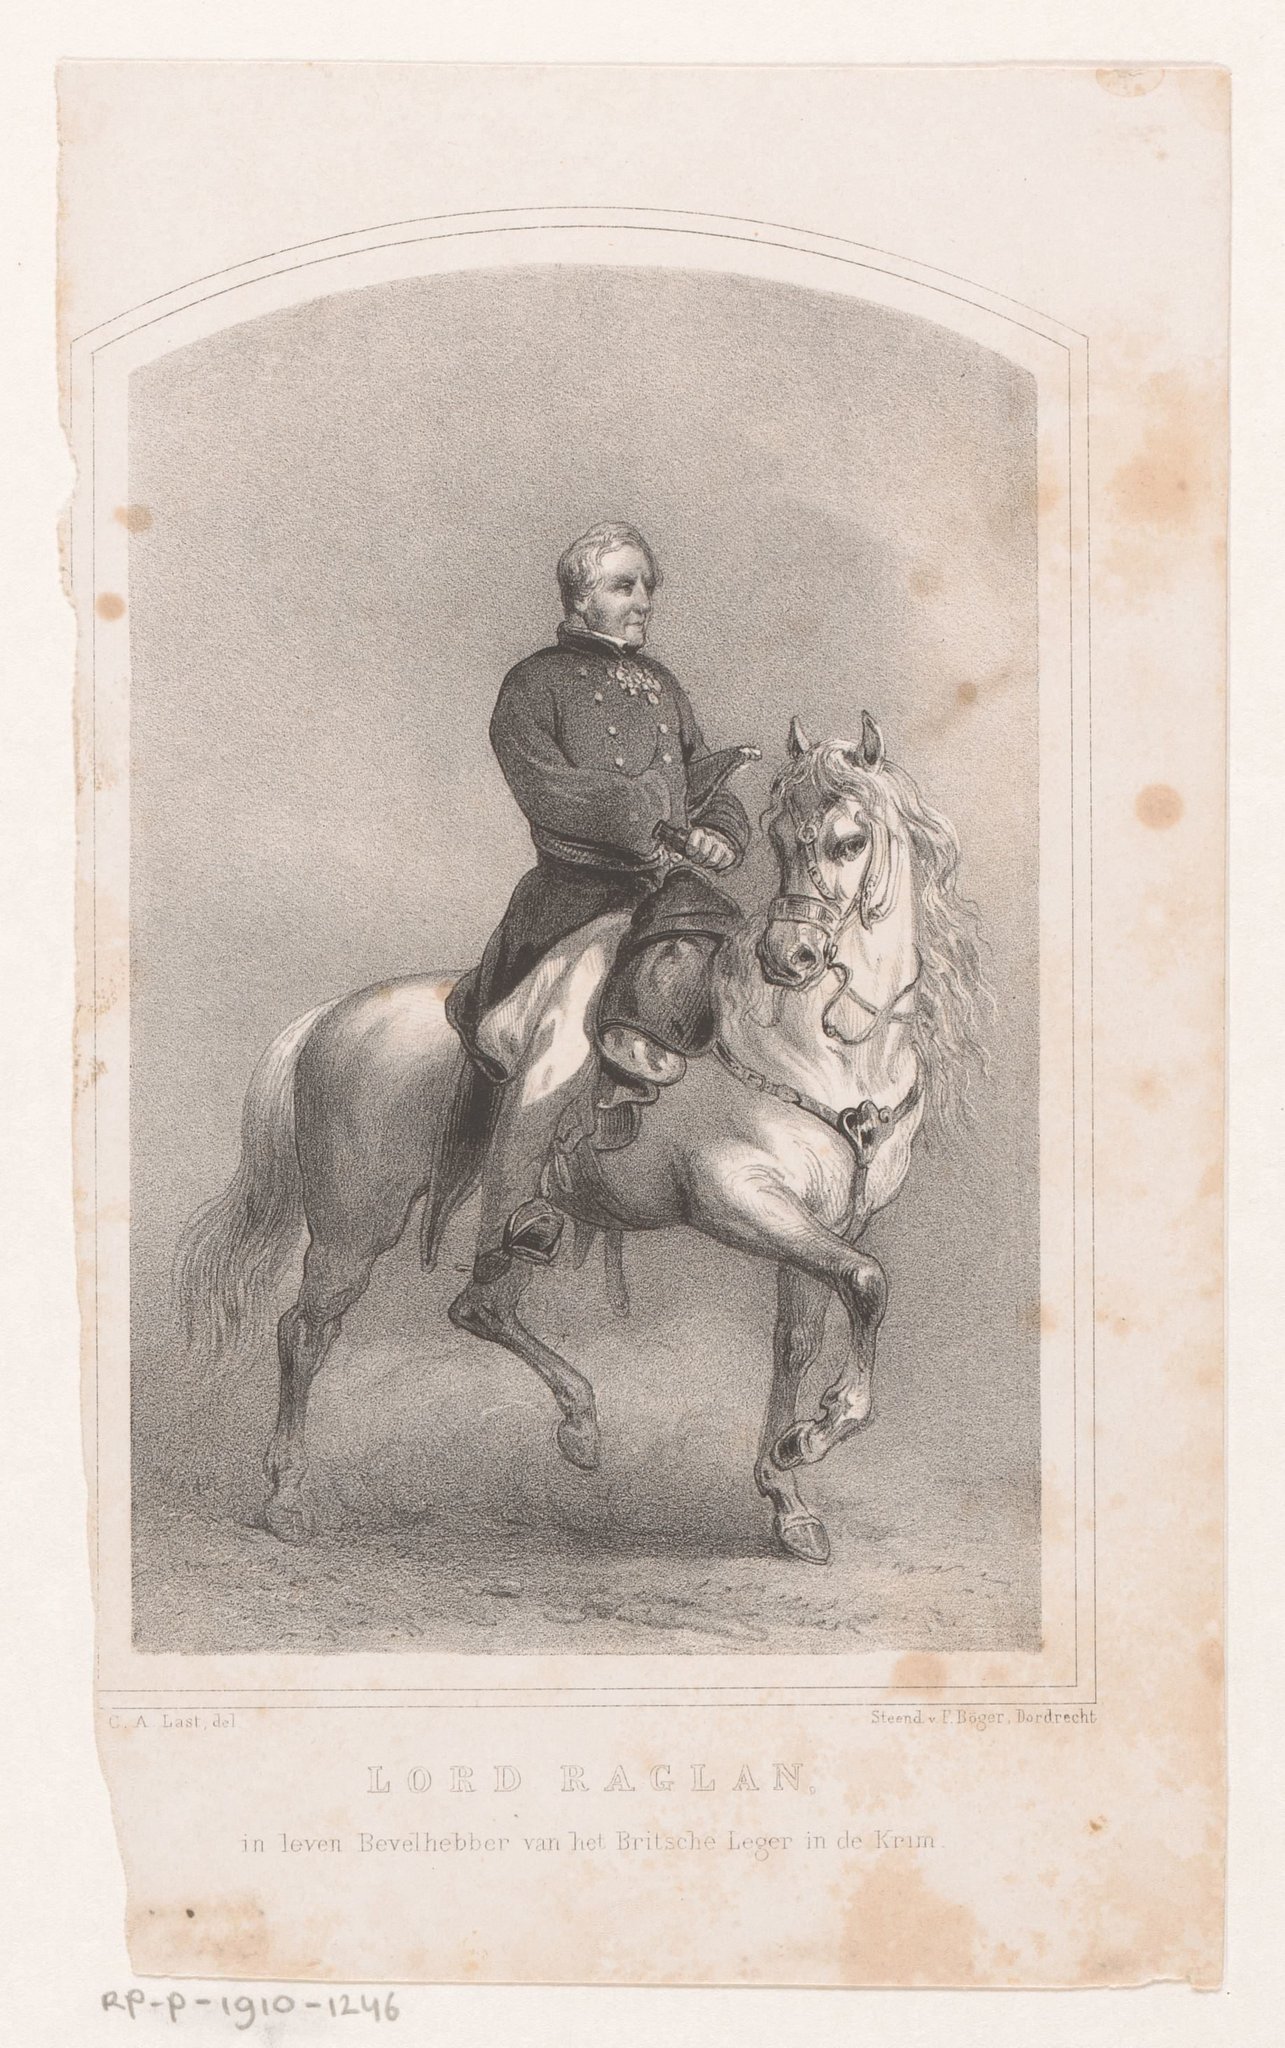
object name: print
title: Lord Raglan, in leven bevelhebber van het Britsche leger in de Krim.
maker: frederik böger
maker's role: printer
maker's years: 1820-1880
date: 1846-1876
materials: paper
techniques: lithograph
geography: dordrecht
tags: equestrian state-portrait, head-gear: bicorne, bicorn, historical persons (+ full length portrait)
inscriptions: collector's mark: Lugt 2228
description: De geportretteerde zit op een dravend paard. Zijn rechterarm werd afgezet. Met zijn linkerhand houdt hij de teugels vast. Onder zijn linkerarm draagt hij zijn bicorn.